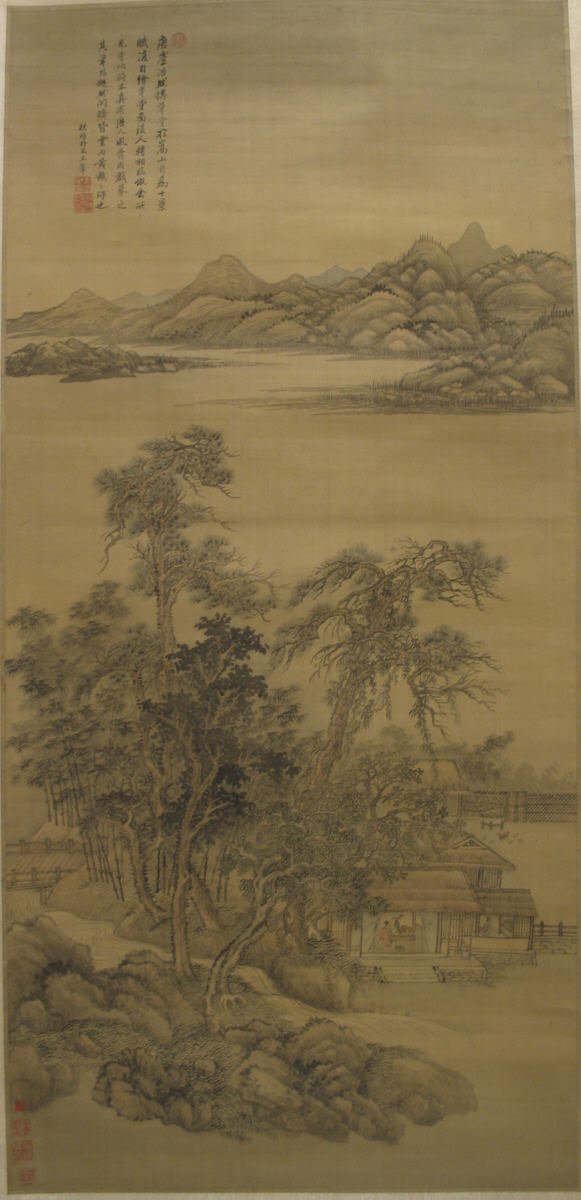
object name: tapestry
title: Landscape in the Style of Li Gonglin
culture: chinese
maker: wang hui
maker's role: artist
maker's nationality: chinese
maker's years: 1632-1717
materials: ink, silk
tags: hills,landscapes